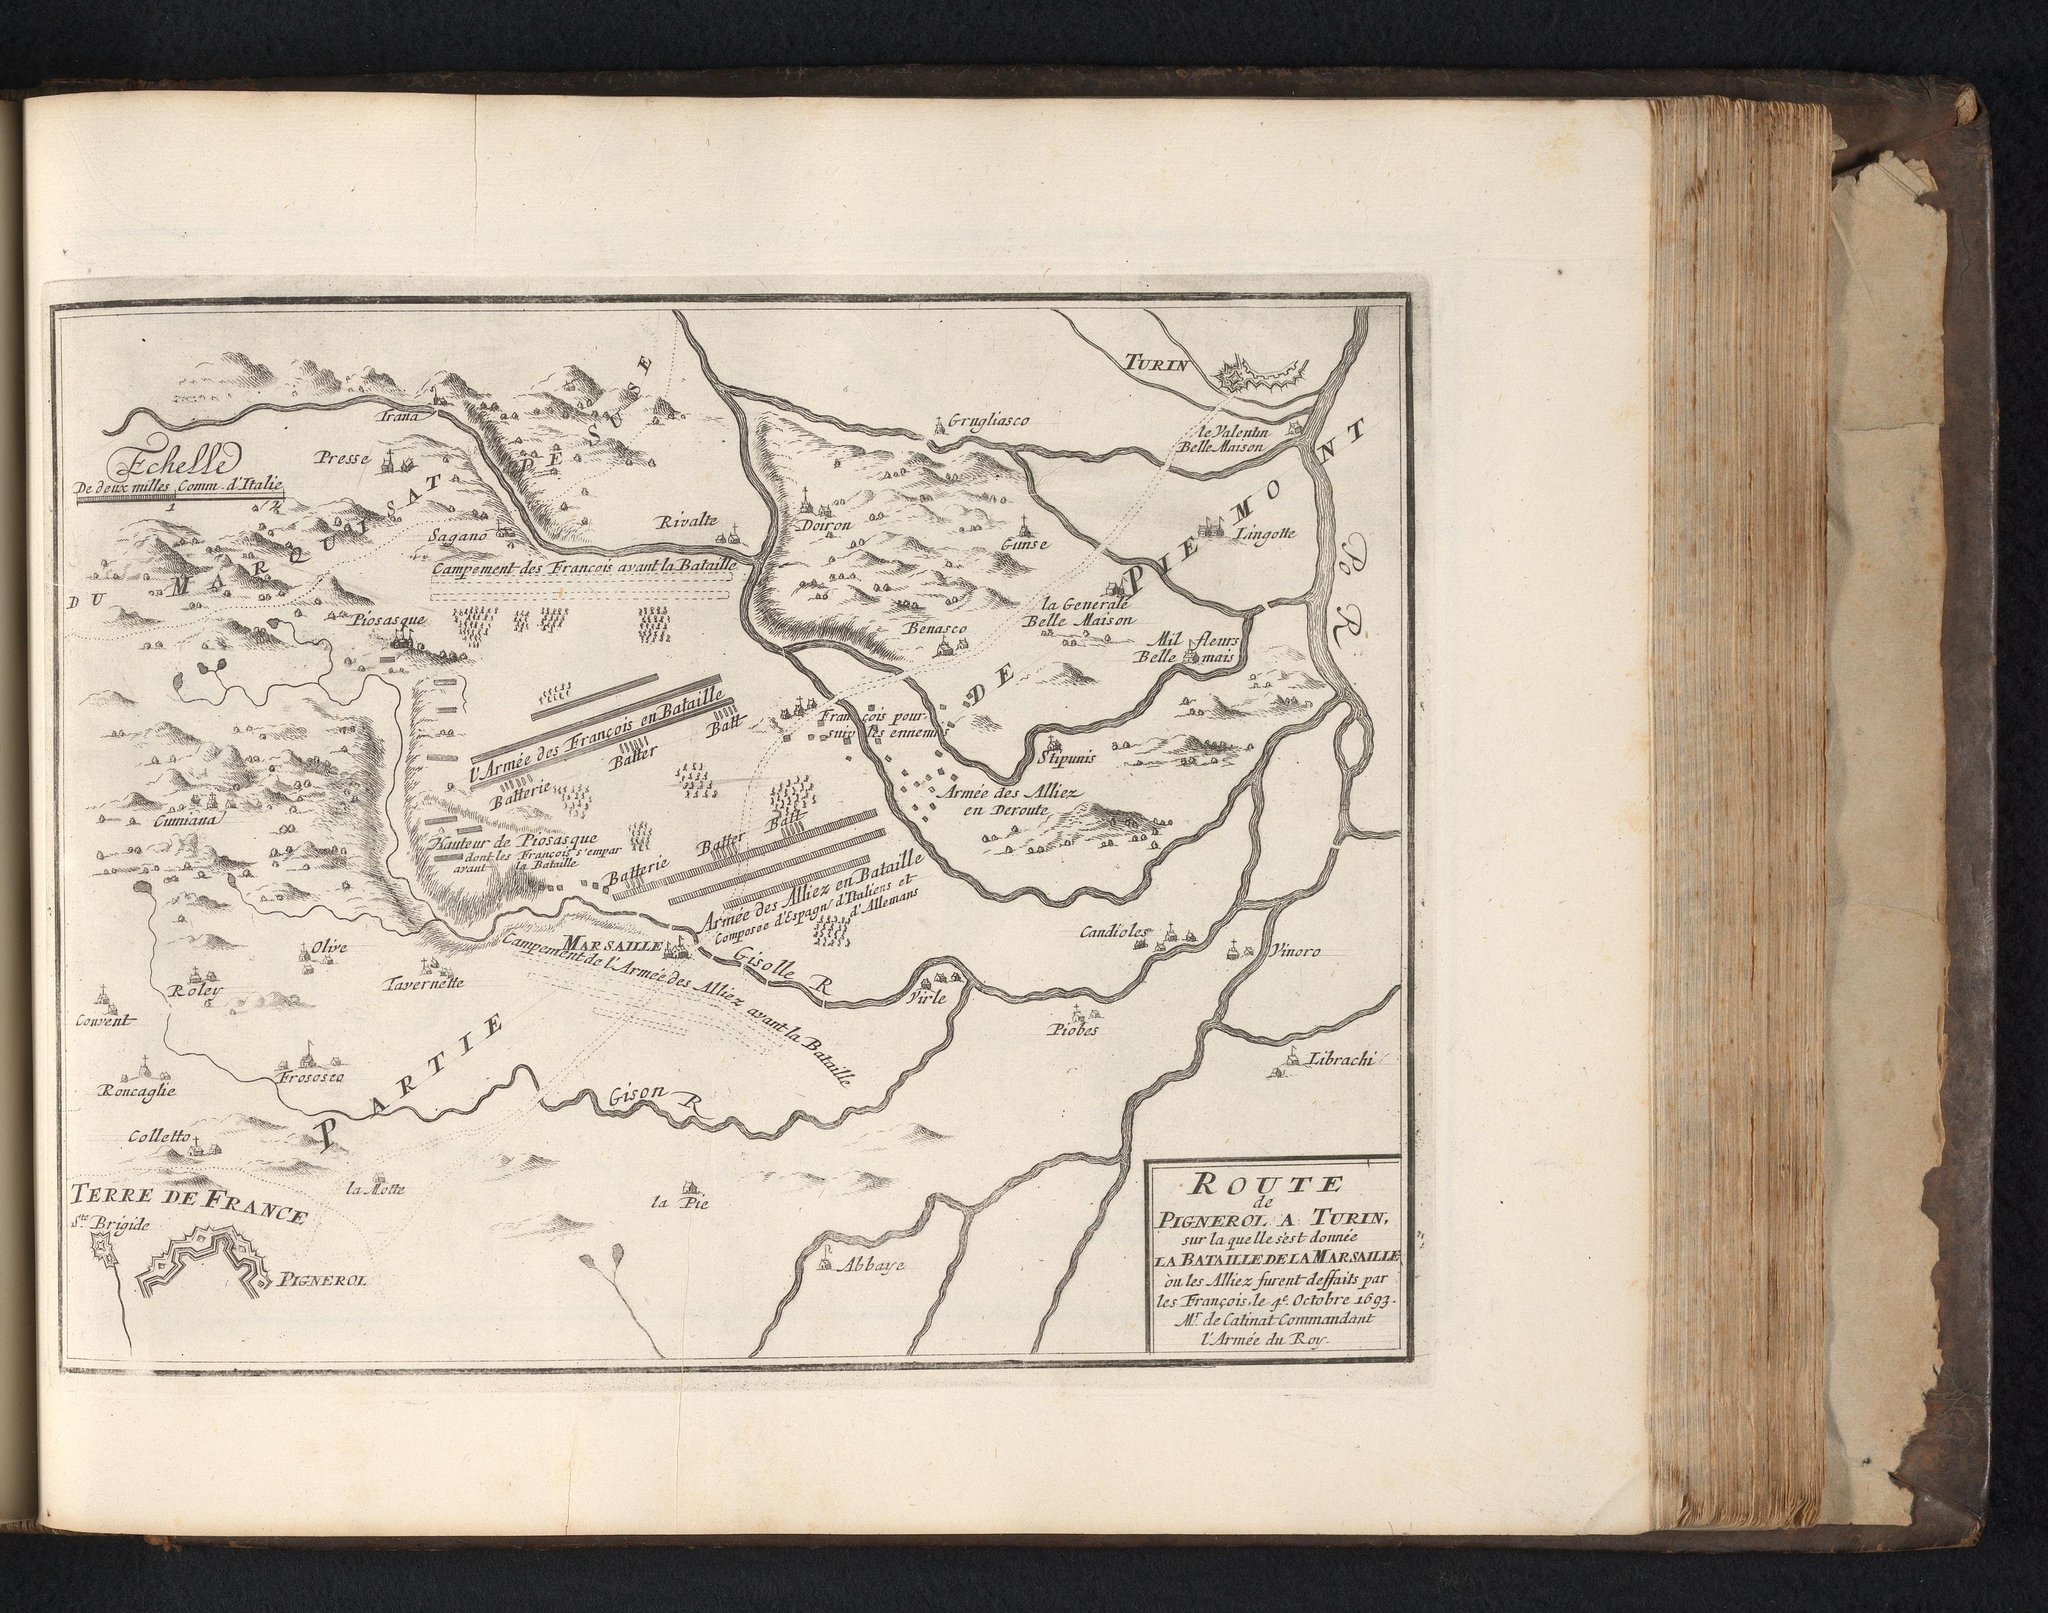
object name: print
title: Kaart met de slag bij Marsaglia, 1693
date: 1693-1696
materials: paper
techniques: etching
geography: paris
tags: maps of separate countries or regions, battle (+ land forces)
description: Kaart van de streek in de Piemonte tussen Turijn en Pinerolo (Pignerol) waar de geallieerden in de slag bij Marsaglia door de Fransen verslagen worden, 4 oktober 1693. Onderdeel van het zevende deel (1696) van het prentwerk waarin gebundeld zijn de acht delen van Les forces de l'Europe uitgegeven tussen 1693-1697. Het prentwerk bestaat uit 175 platen met plannen (afkomstig van Sébastien Le Prestre, Seigneur de Vauban) van vermaarde sterke steden en vestingen in de Negenjarige Oorlog. Titel en opschriften in het Frans.